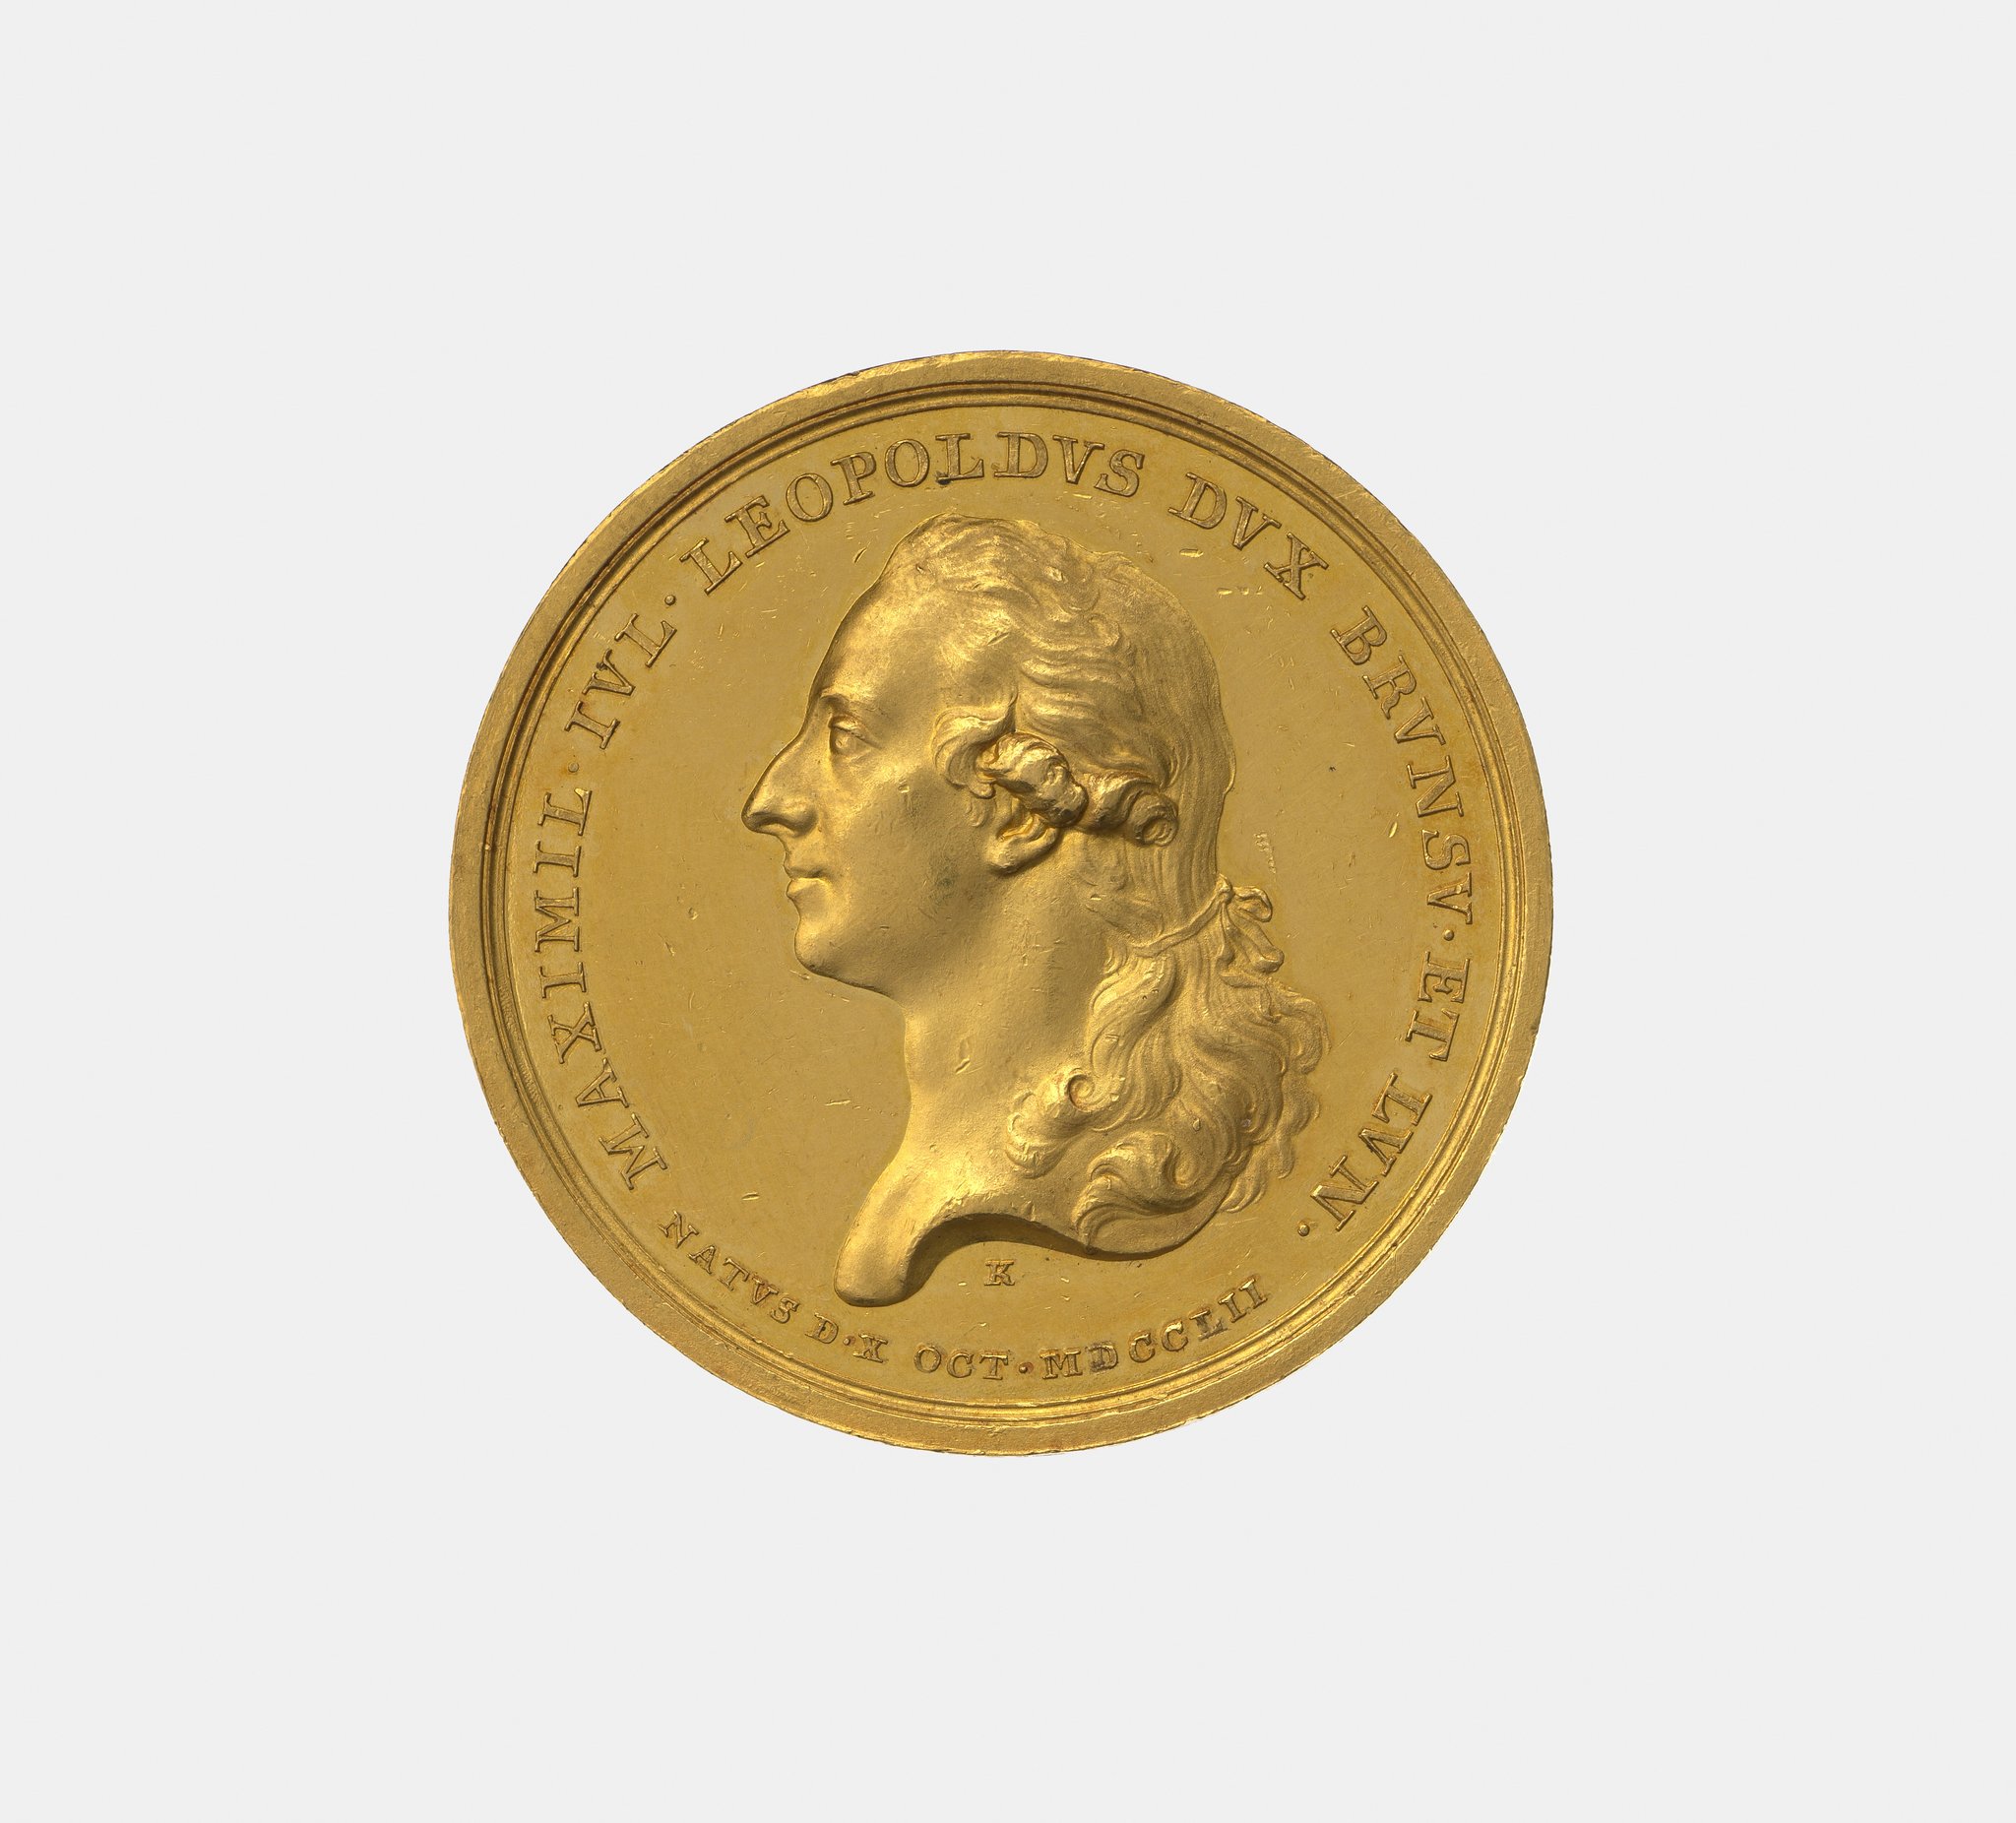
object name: medal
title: Maximillian Julius Leopold, Duke of Brunswick-Lüneburg commemorative medal with Masonic motif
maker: christian friedrich krull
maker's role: artist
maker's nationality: german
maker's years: 1748-1787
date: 1785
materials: gold